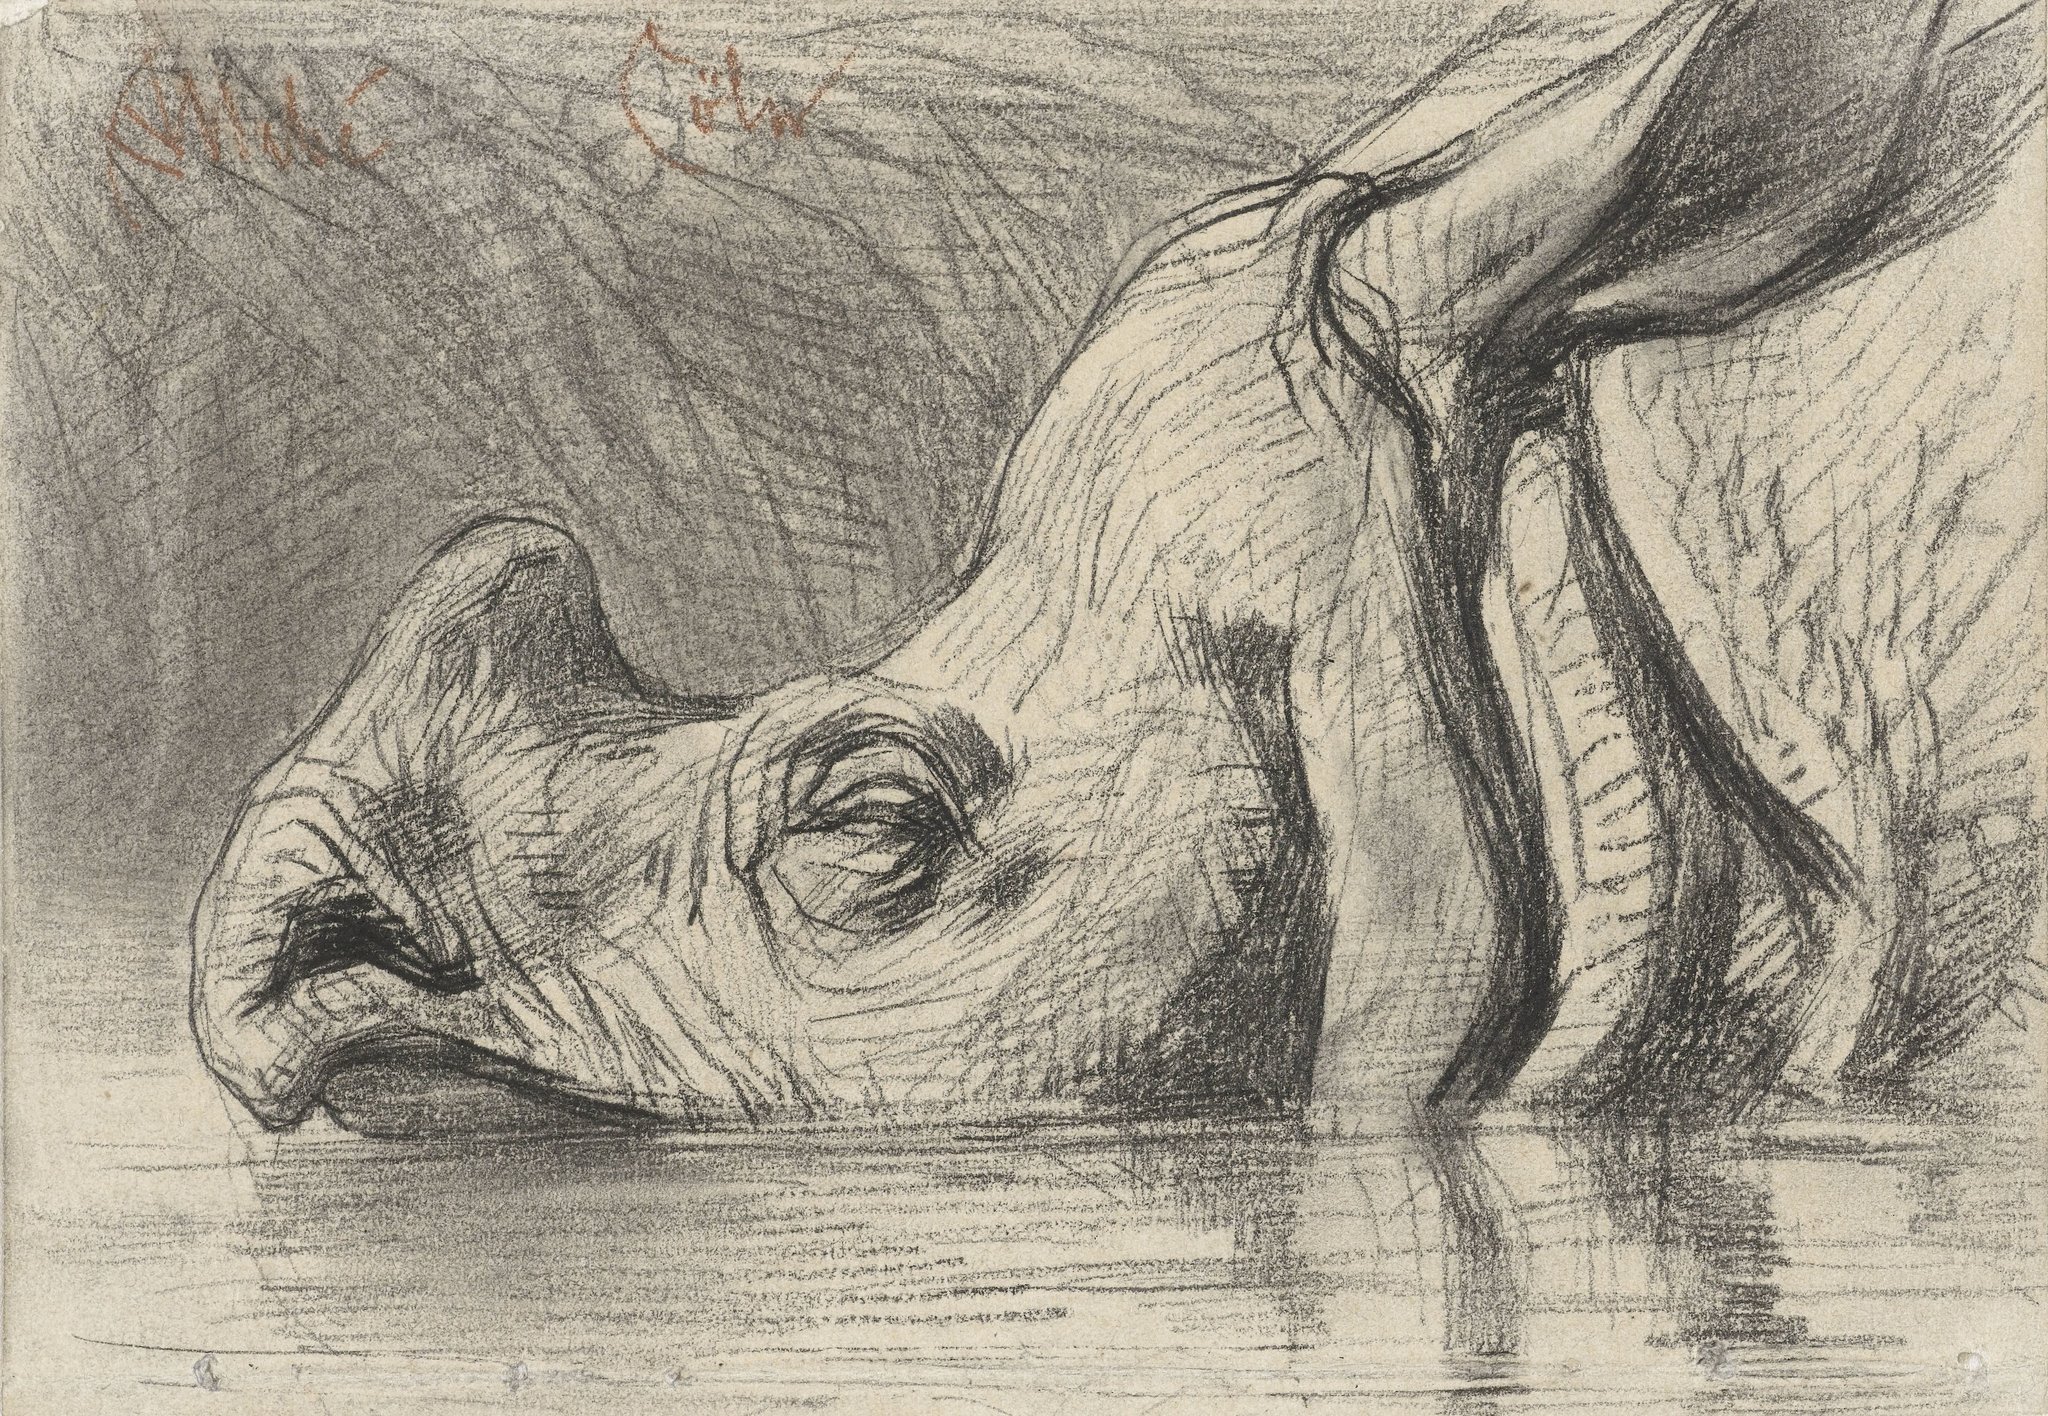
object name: drawing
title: Head of a Rhinoceros, Half Submerged in the Water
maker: august allebé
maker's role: draughtsman, print maker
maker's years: 1838-1927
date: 1870-1884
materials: chalk, paper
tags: hoofed animals: rhinoceros (+ head of an animal)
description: As a professor of drawing, anatomy and proportions at the Rijksakademie van beeldende kunsten in Amsterdam, August Allebé regularly took his students to draw in Artis Zoo. He was known as a friendly, yet critical teacher who made his students practice until they got the depiction right. To set a good example, he also made studies of the animals during these lessons.